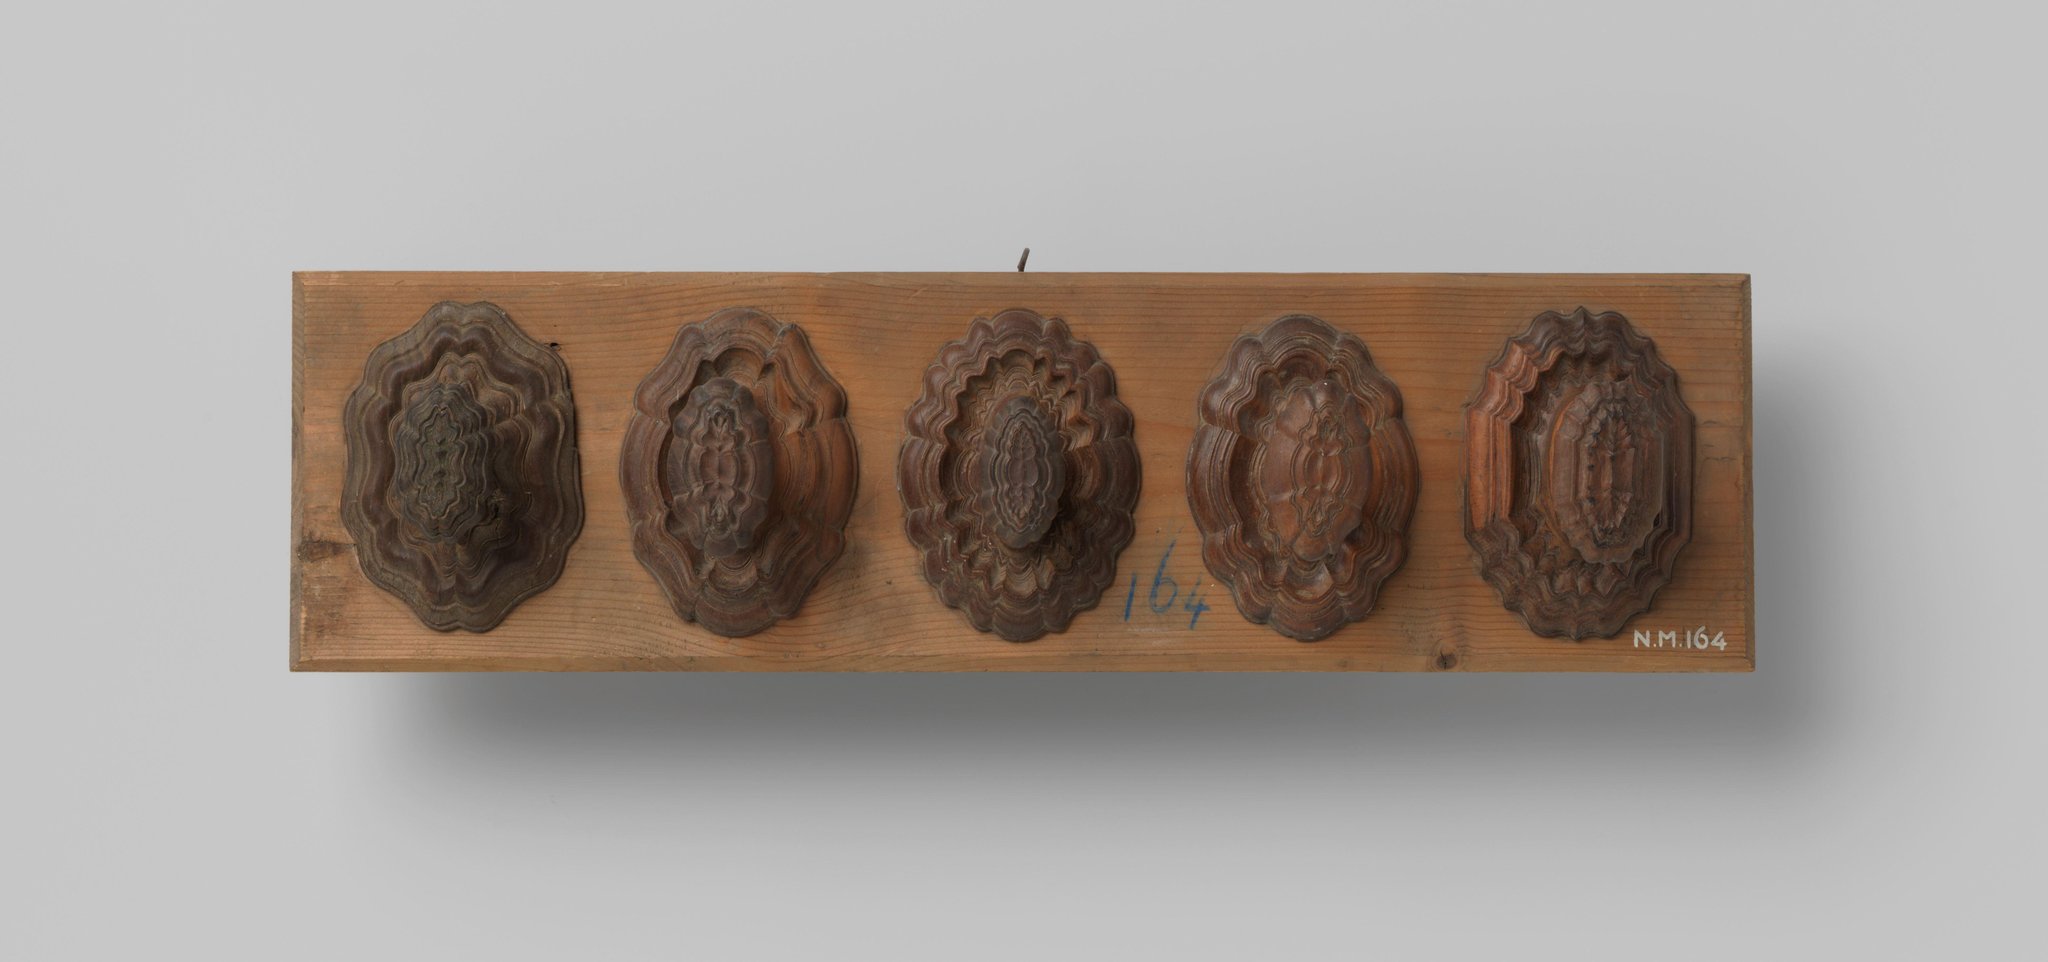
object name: architectural element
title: Deurkruk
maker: Anonymous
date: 1700-1800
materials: wood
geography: netherlands